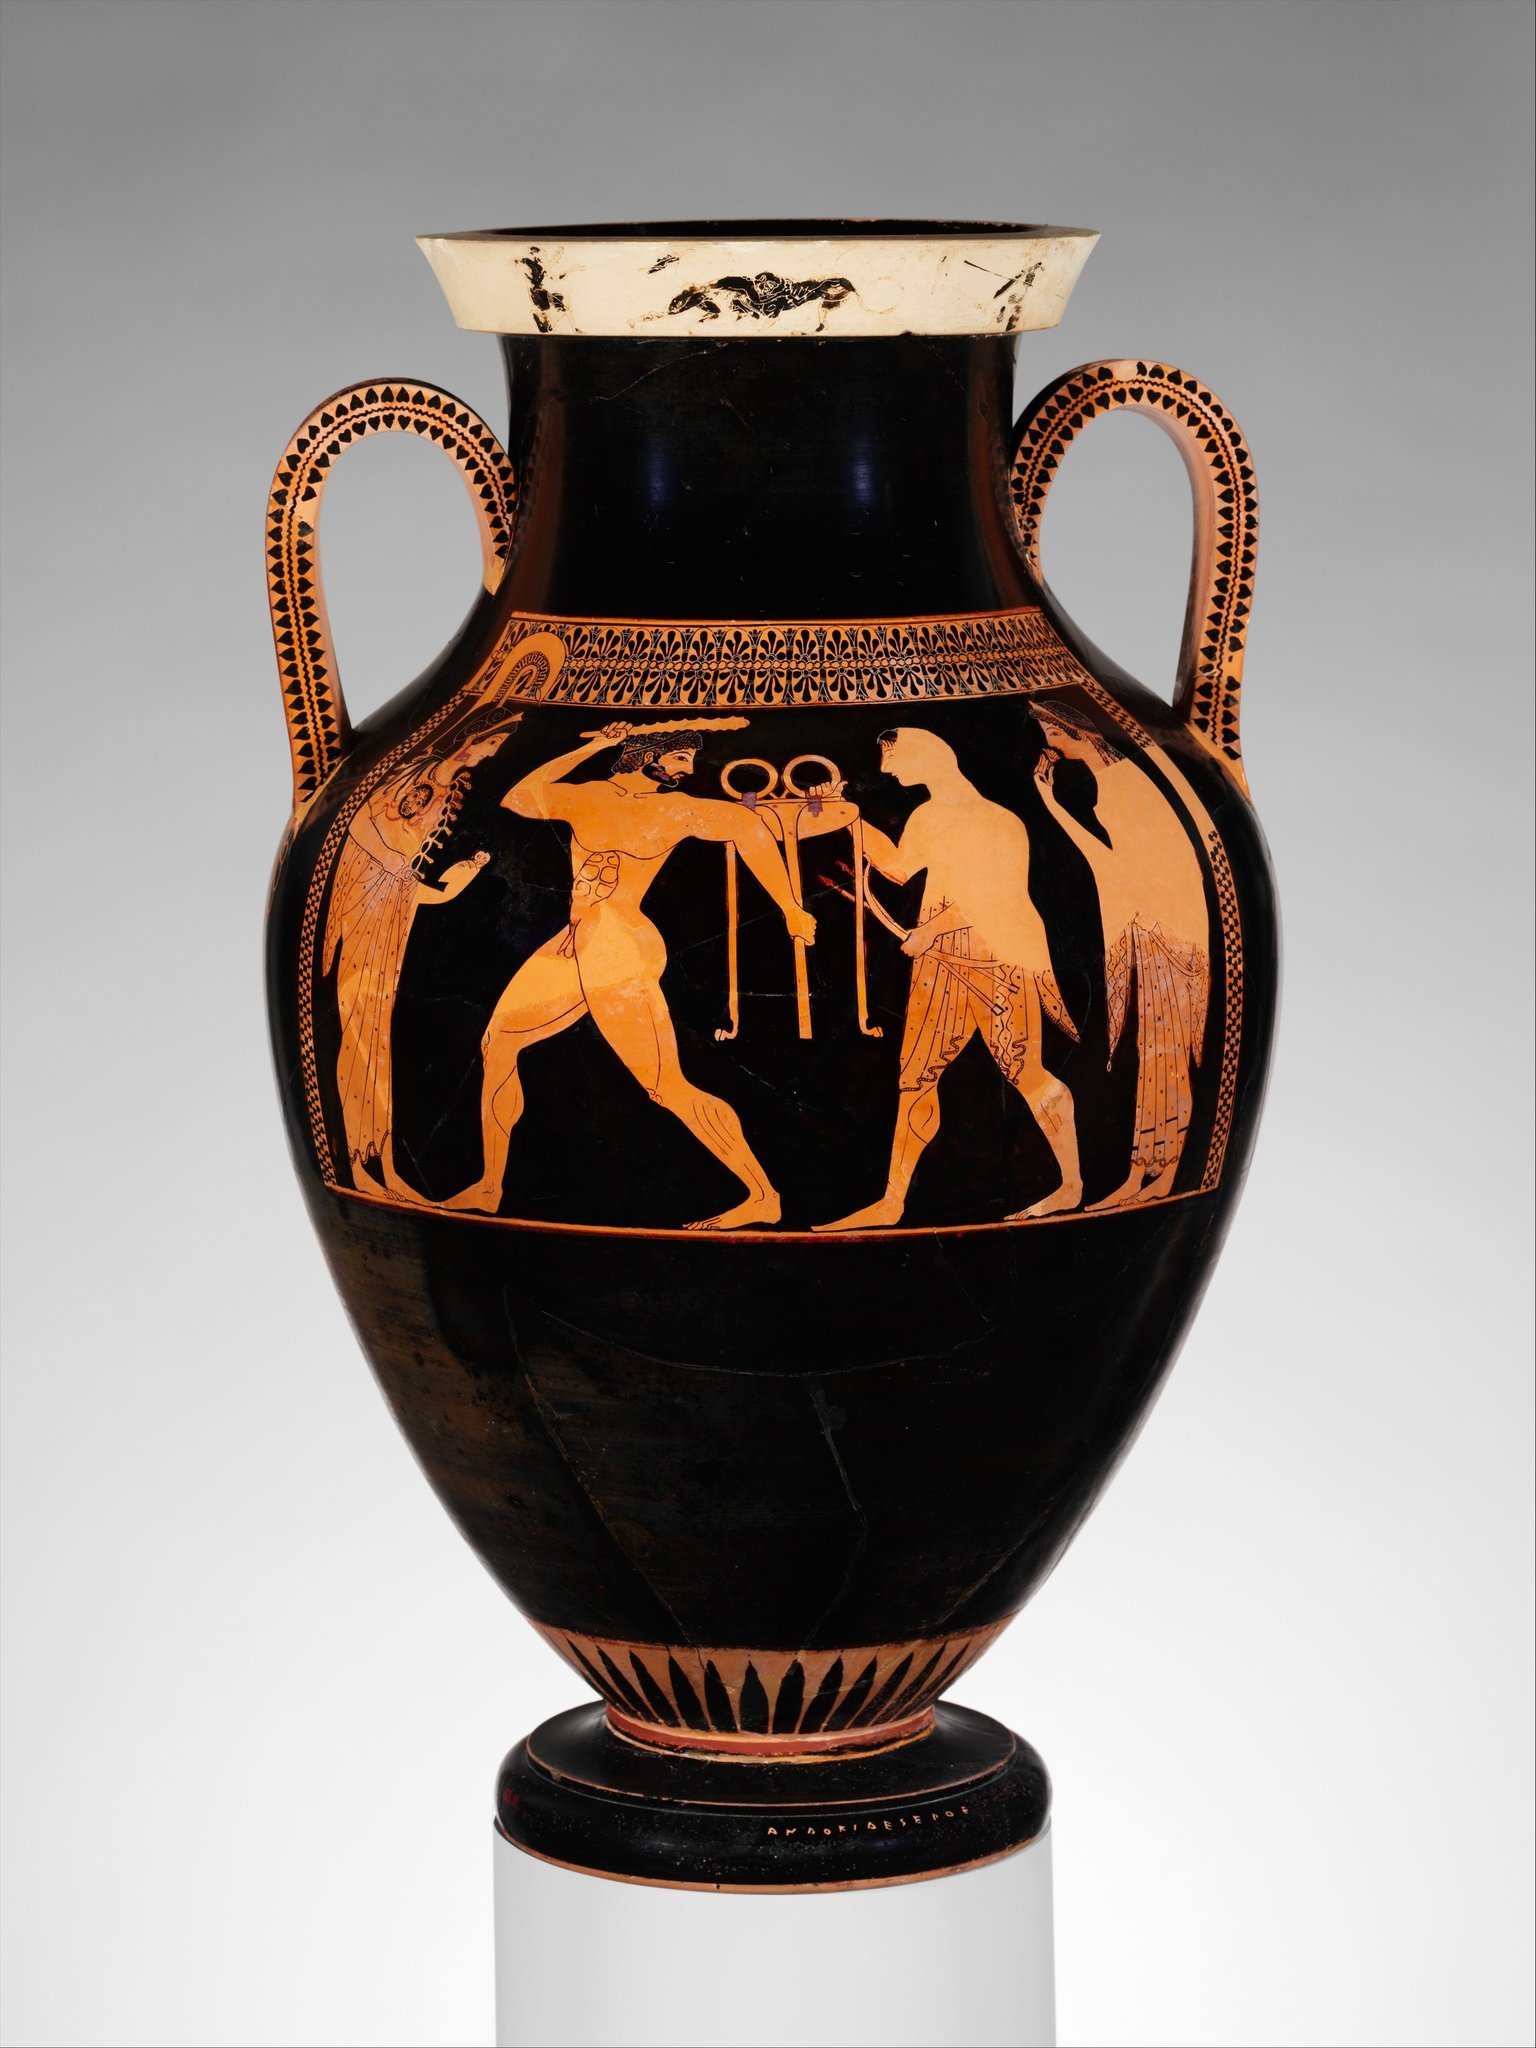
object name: amphora, type a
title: Terracotta amphora (jar)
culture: greek, attic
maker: andokides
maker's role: artist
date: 530 BCE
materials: terracotta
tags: apollo,dionysus,maenads,satyrs,herakles